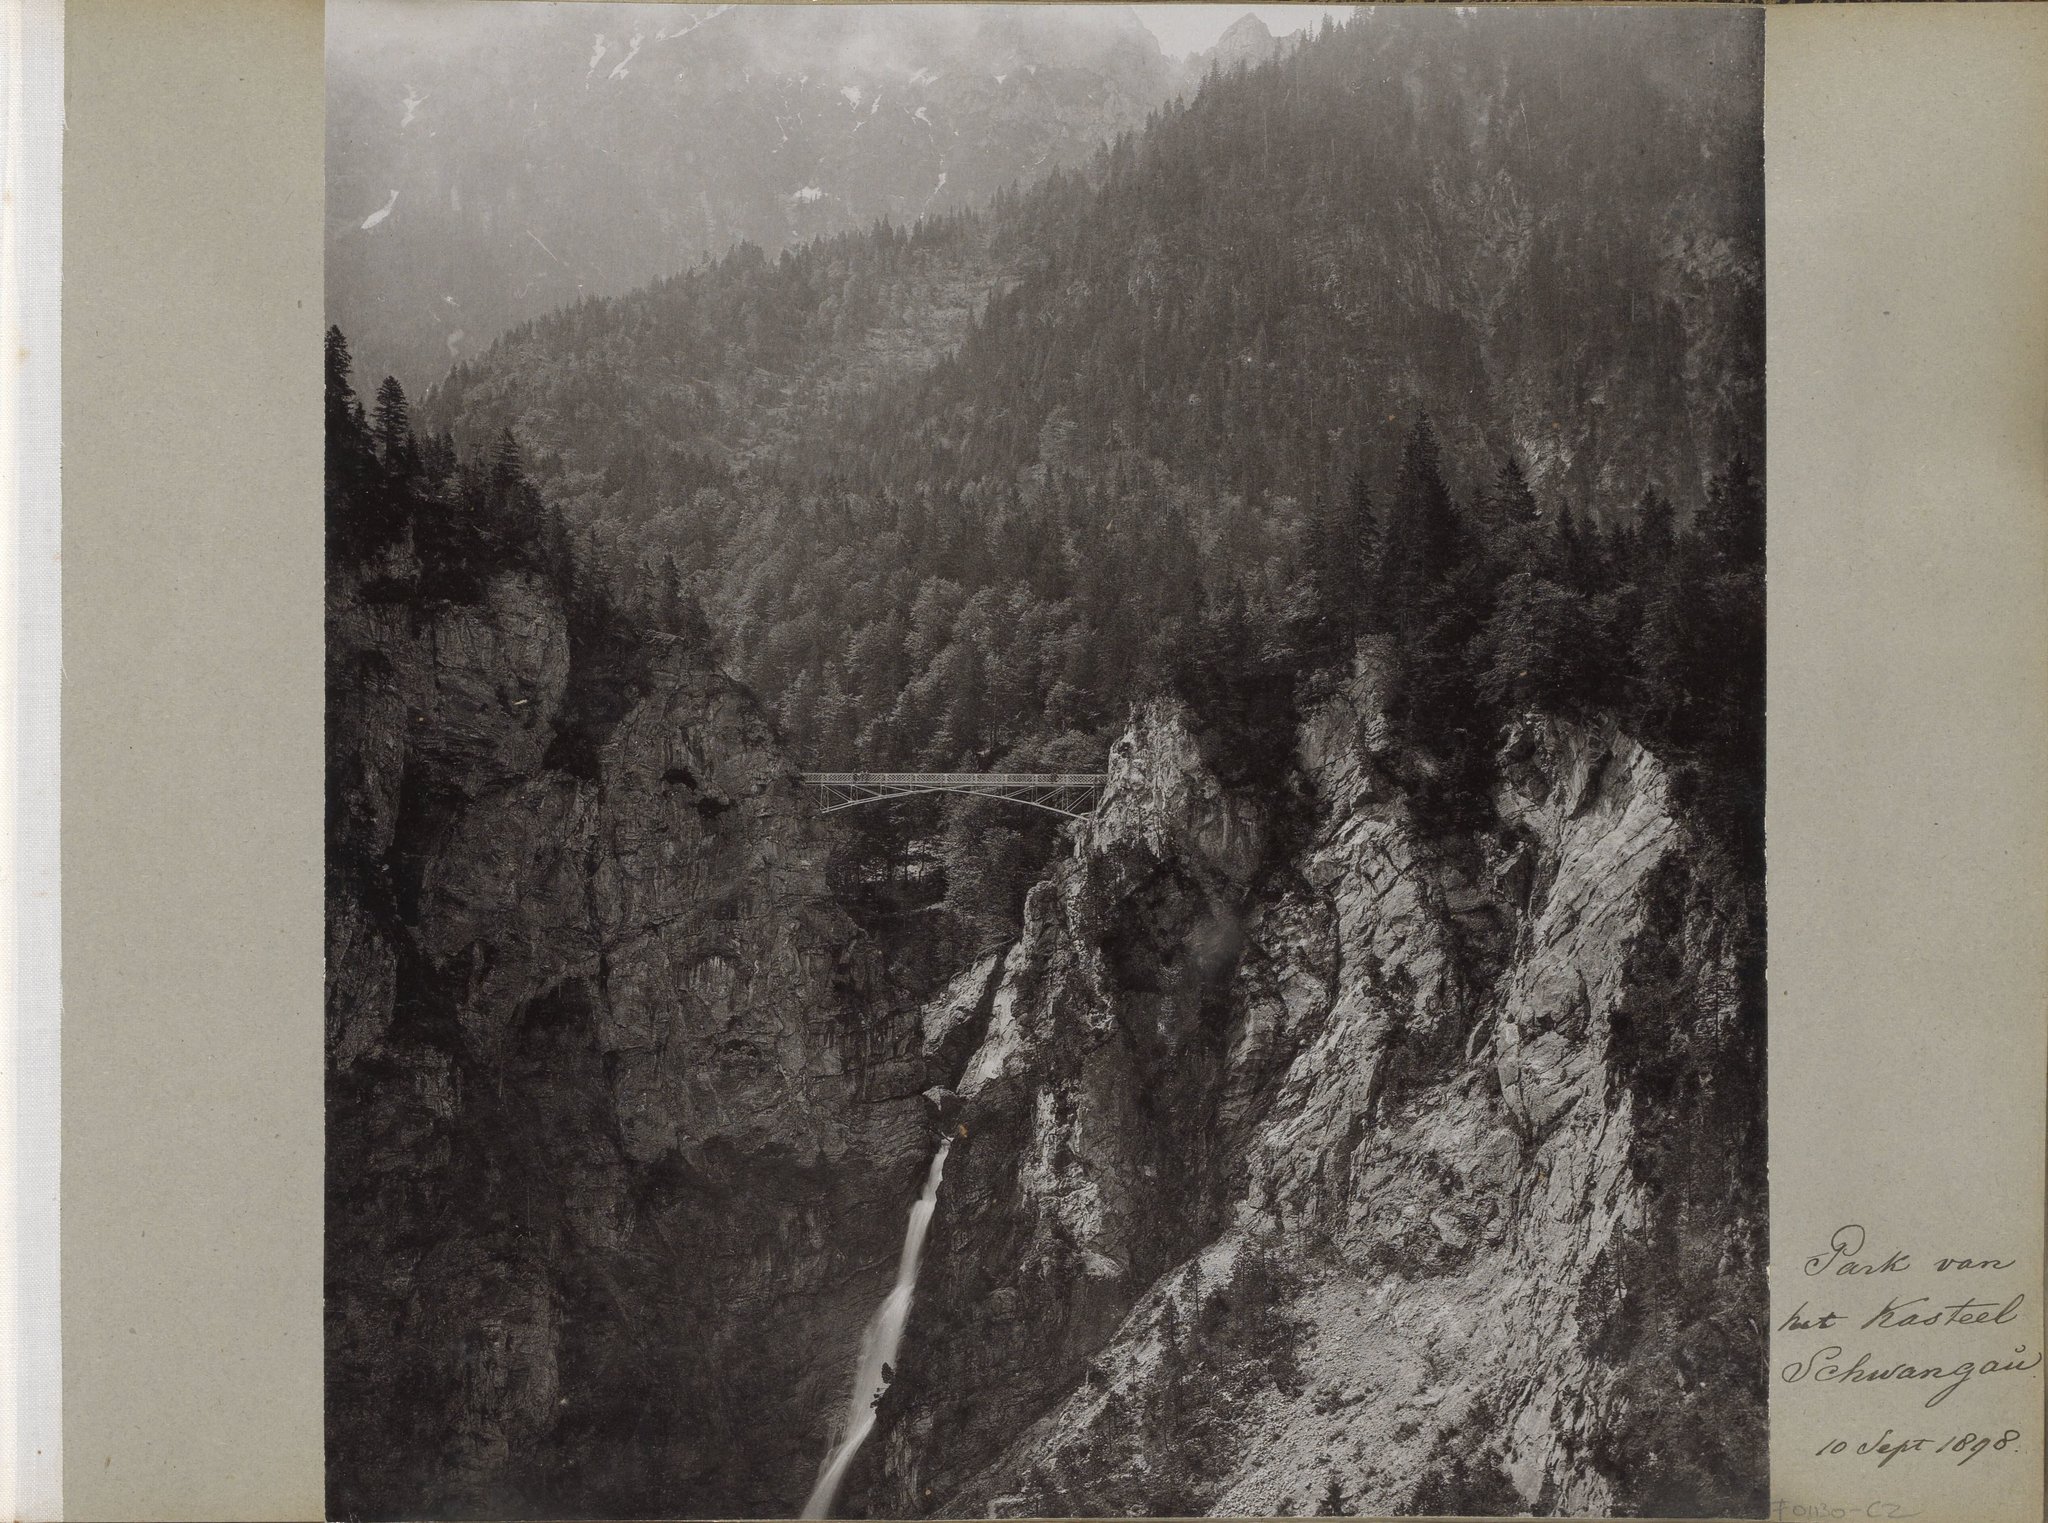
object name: photograph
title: Gezicht op een brug en een bij waterval slot Neuschwanstein in Beieren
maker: joseph albert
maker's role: printer, publisher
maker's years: 1825-1886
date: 1857-1886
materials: paper, photographic support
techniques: photography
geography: bavaria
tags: waterfall, landscape with bridge, viaduct or aqueduct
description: Onderdeel van Reisalbum met foto's van bezienswaardigheden in Frankrijk, Spanje, Italië, Duitsland, Zwitserland en Oostenrijk.